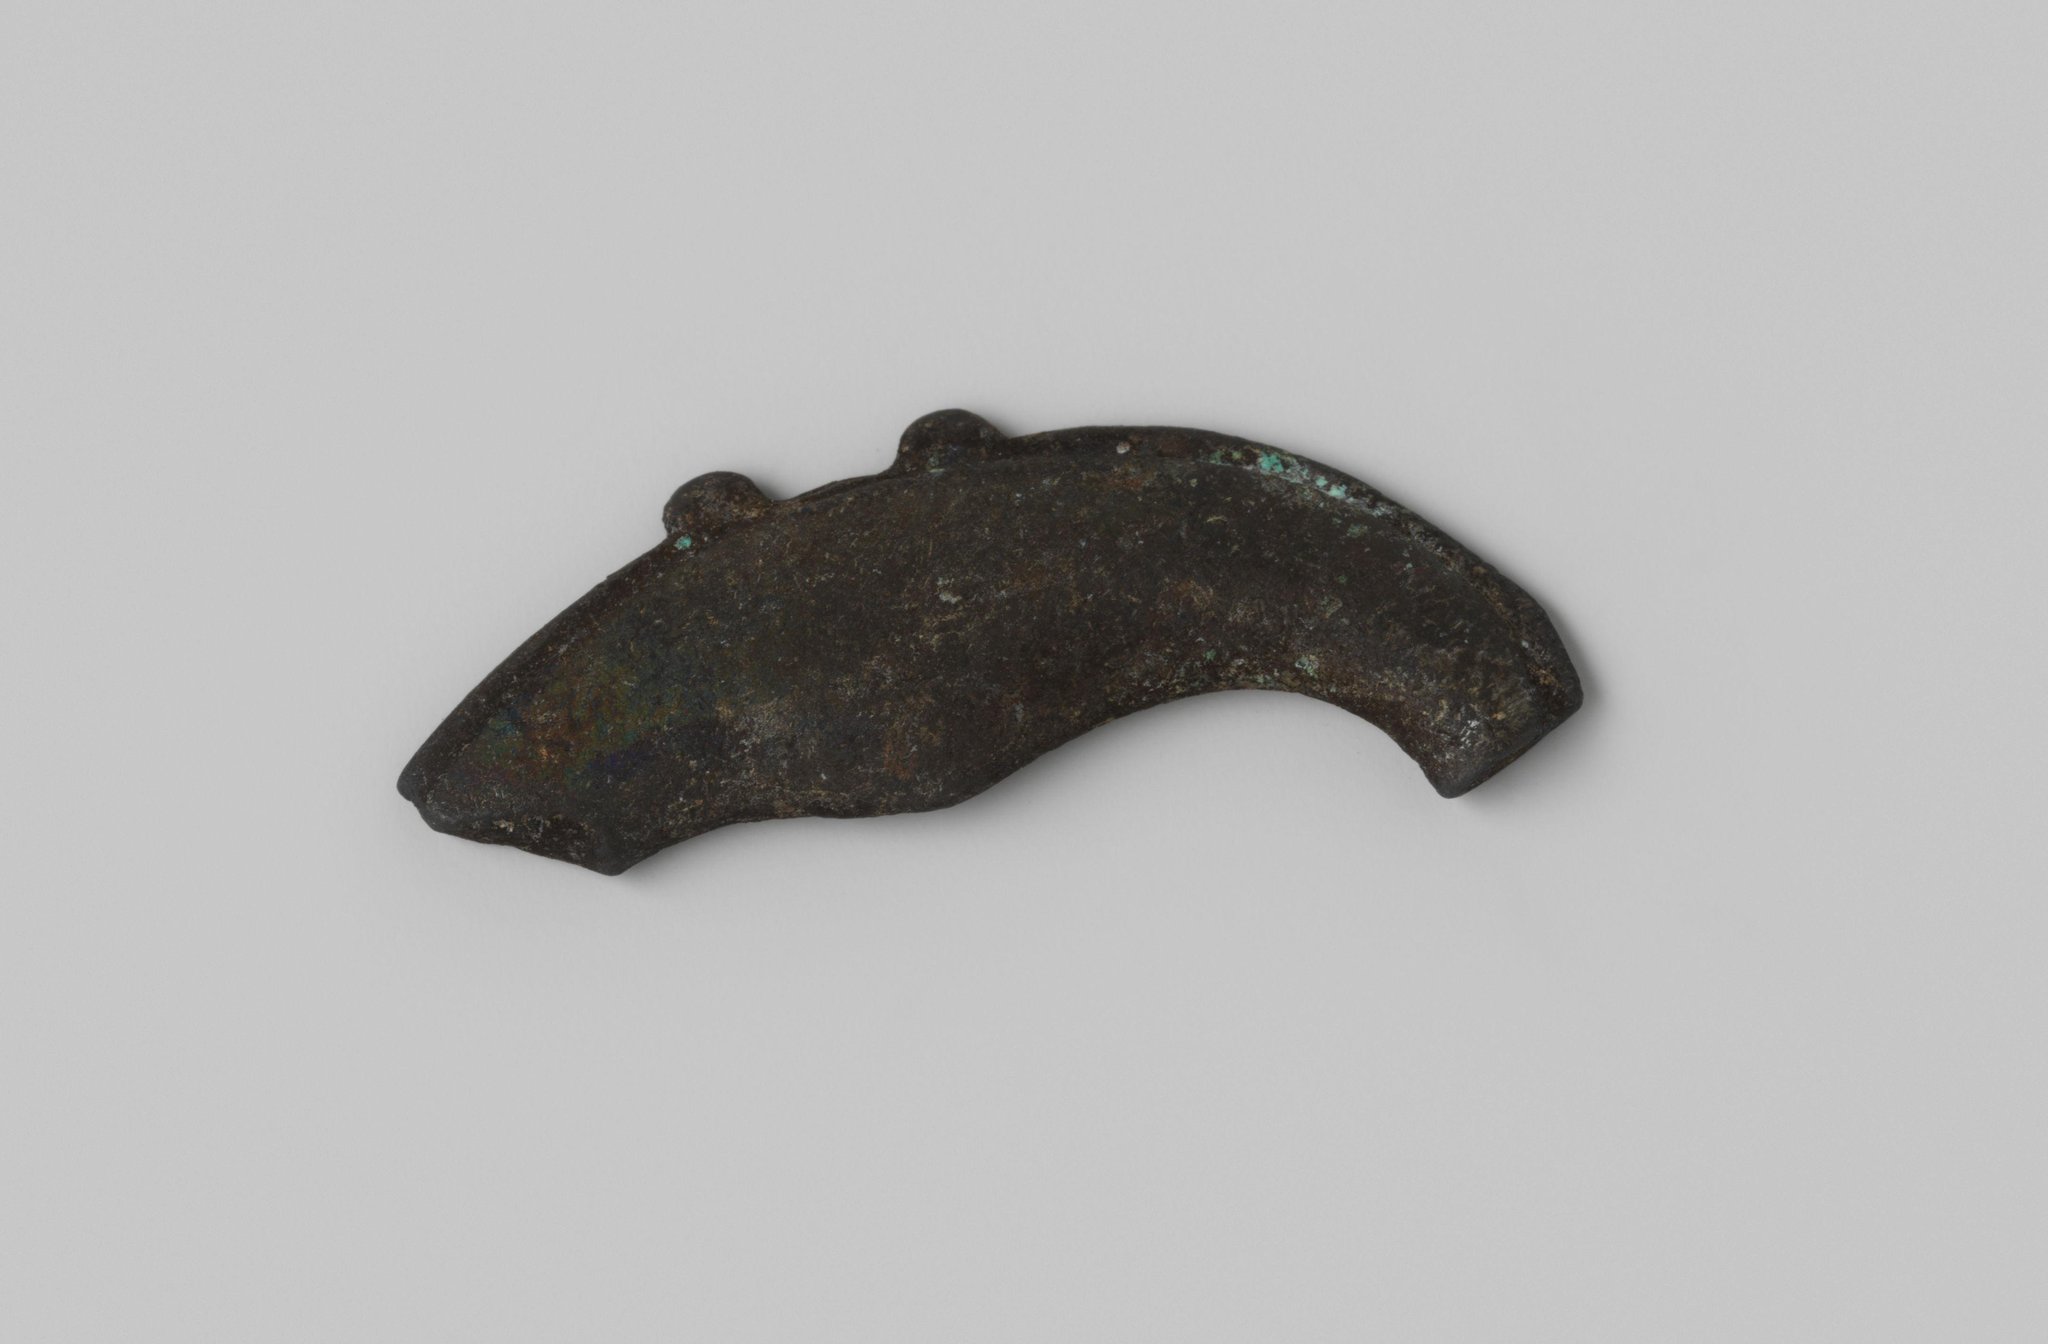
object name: buckle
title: Fragment van een gesp uit het wrak van de Oost-Indiëvaarder Hollandia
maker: Anonymous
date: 1700-1743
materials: copper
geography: netherlands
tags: verenigde oostindische compagnie, hollandia (schip), annet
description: Buckle, not identifiable; fragm of ring, curving short side with two knobbed projections.